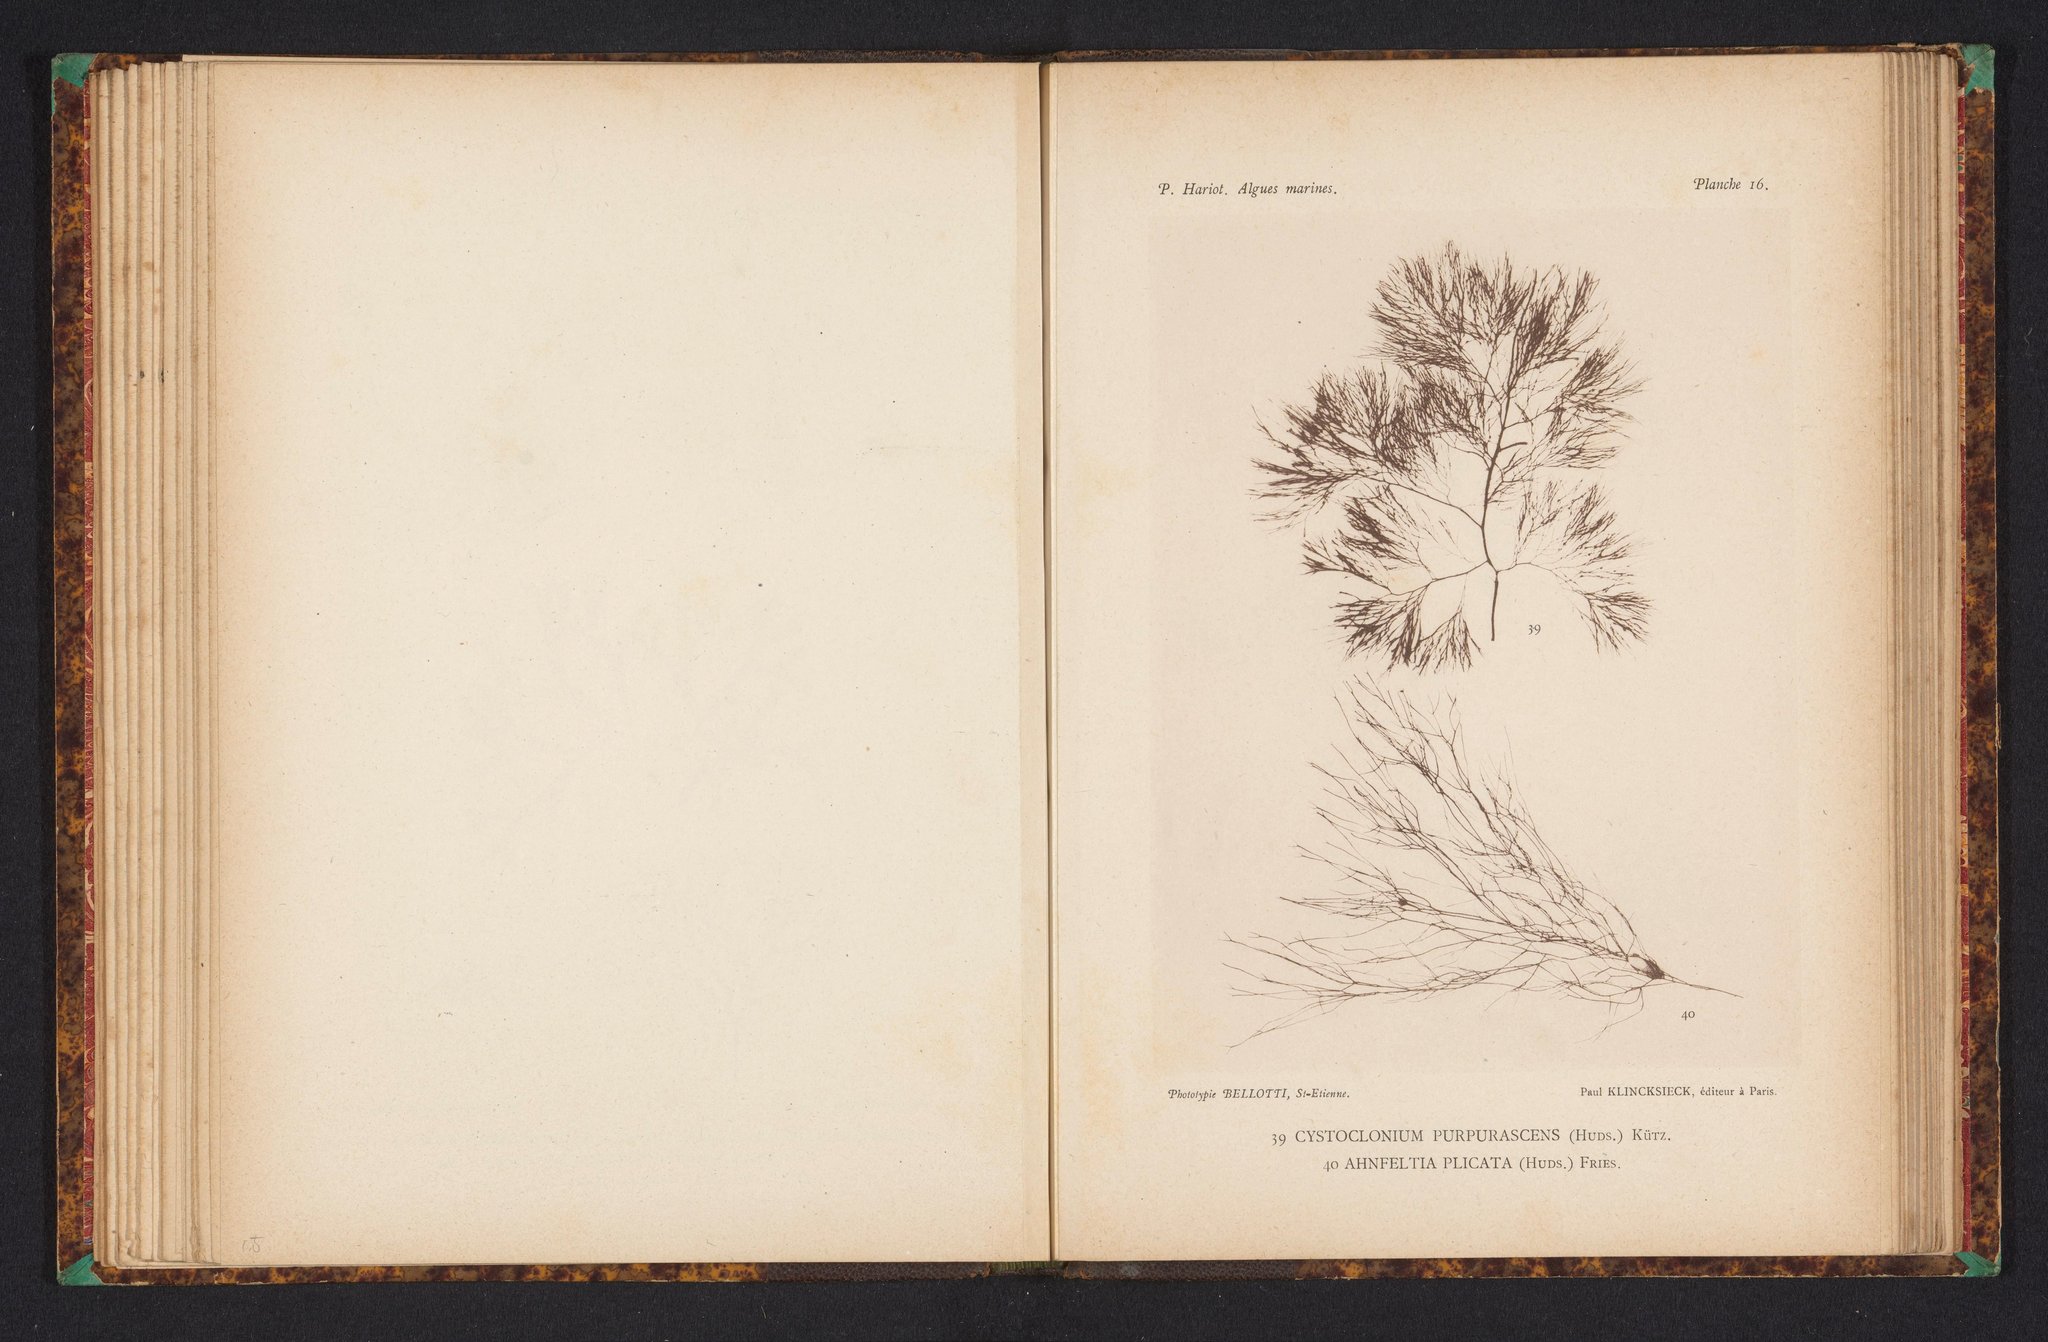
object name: page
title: Twee soorten zeewier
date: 1882-1892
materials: paper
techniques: photograph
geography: saint-étienne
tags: algae, seaweed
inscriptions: number: ‘39 (...) 40’, inscription: ‘Cystoclonium (...) plicata (Huds.) Fries.’, number: ‘Planche 16.’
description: (39) is Cystoclonium purpureum, (40) is Ahnfeltia plicata.